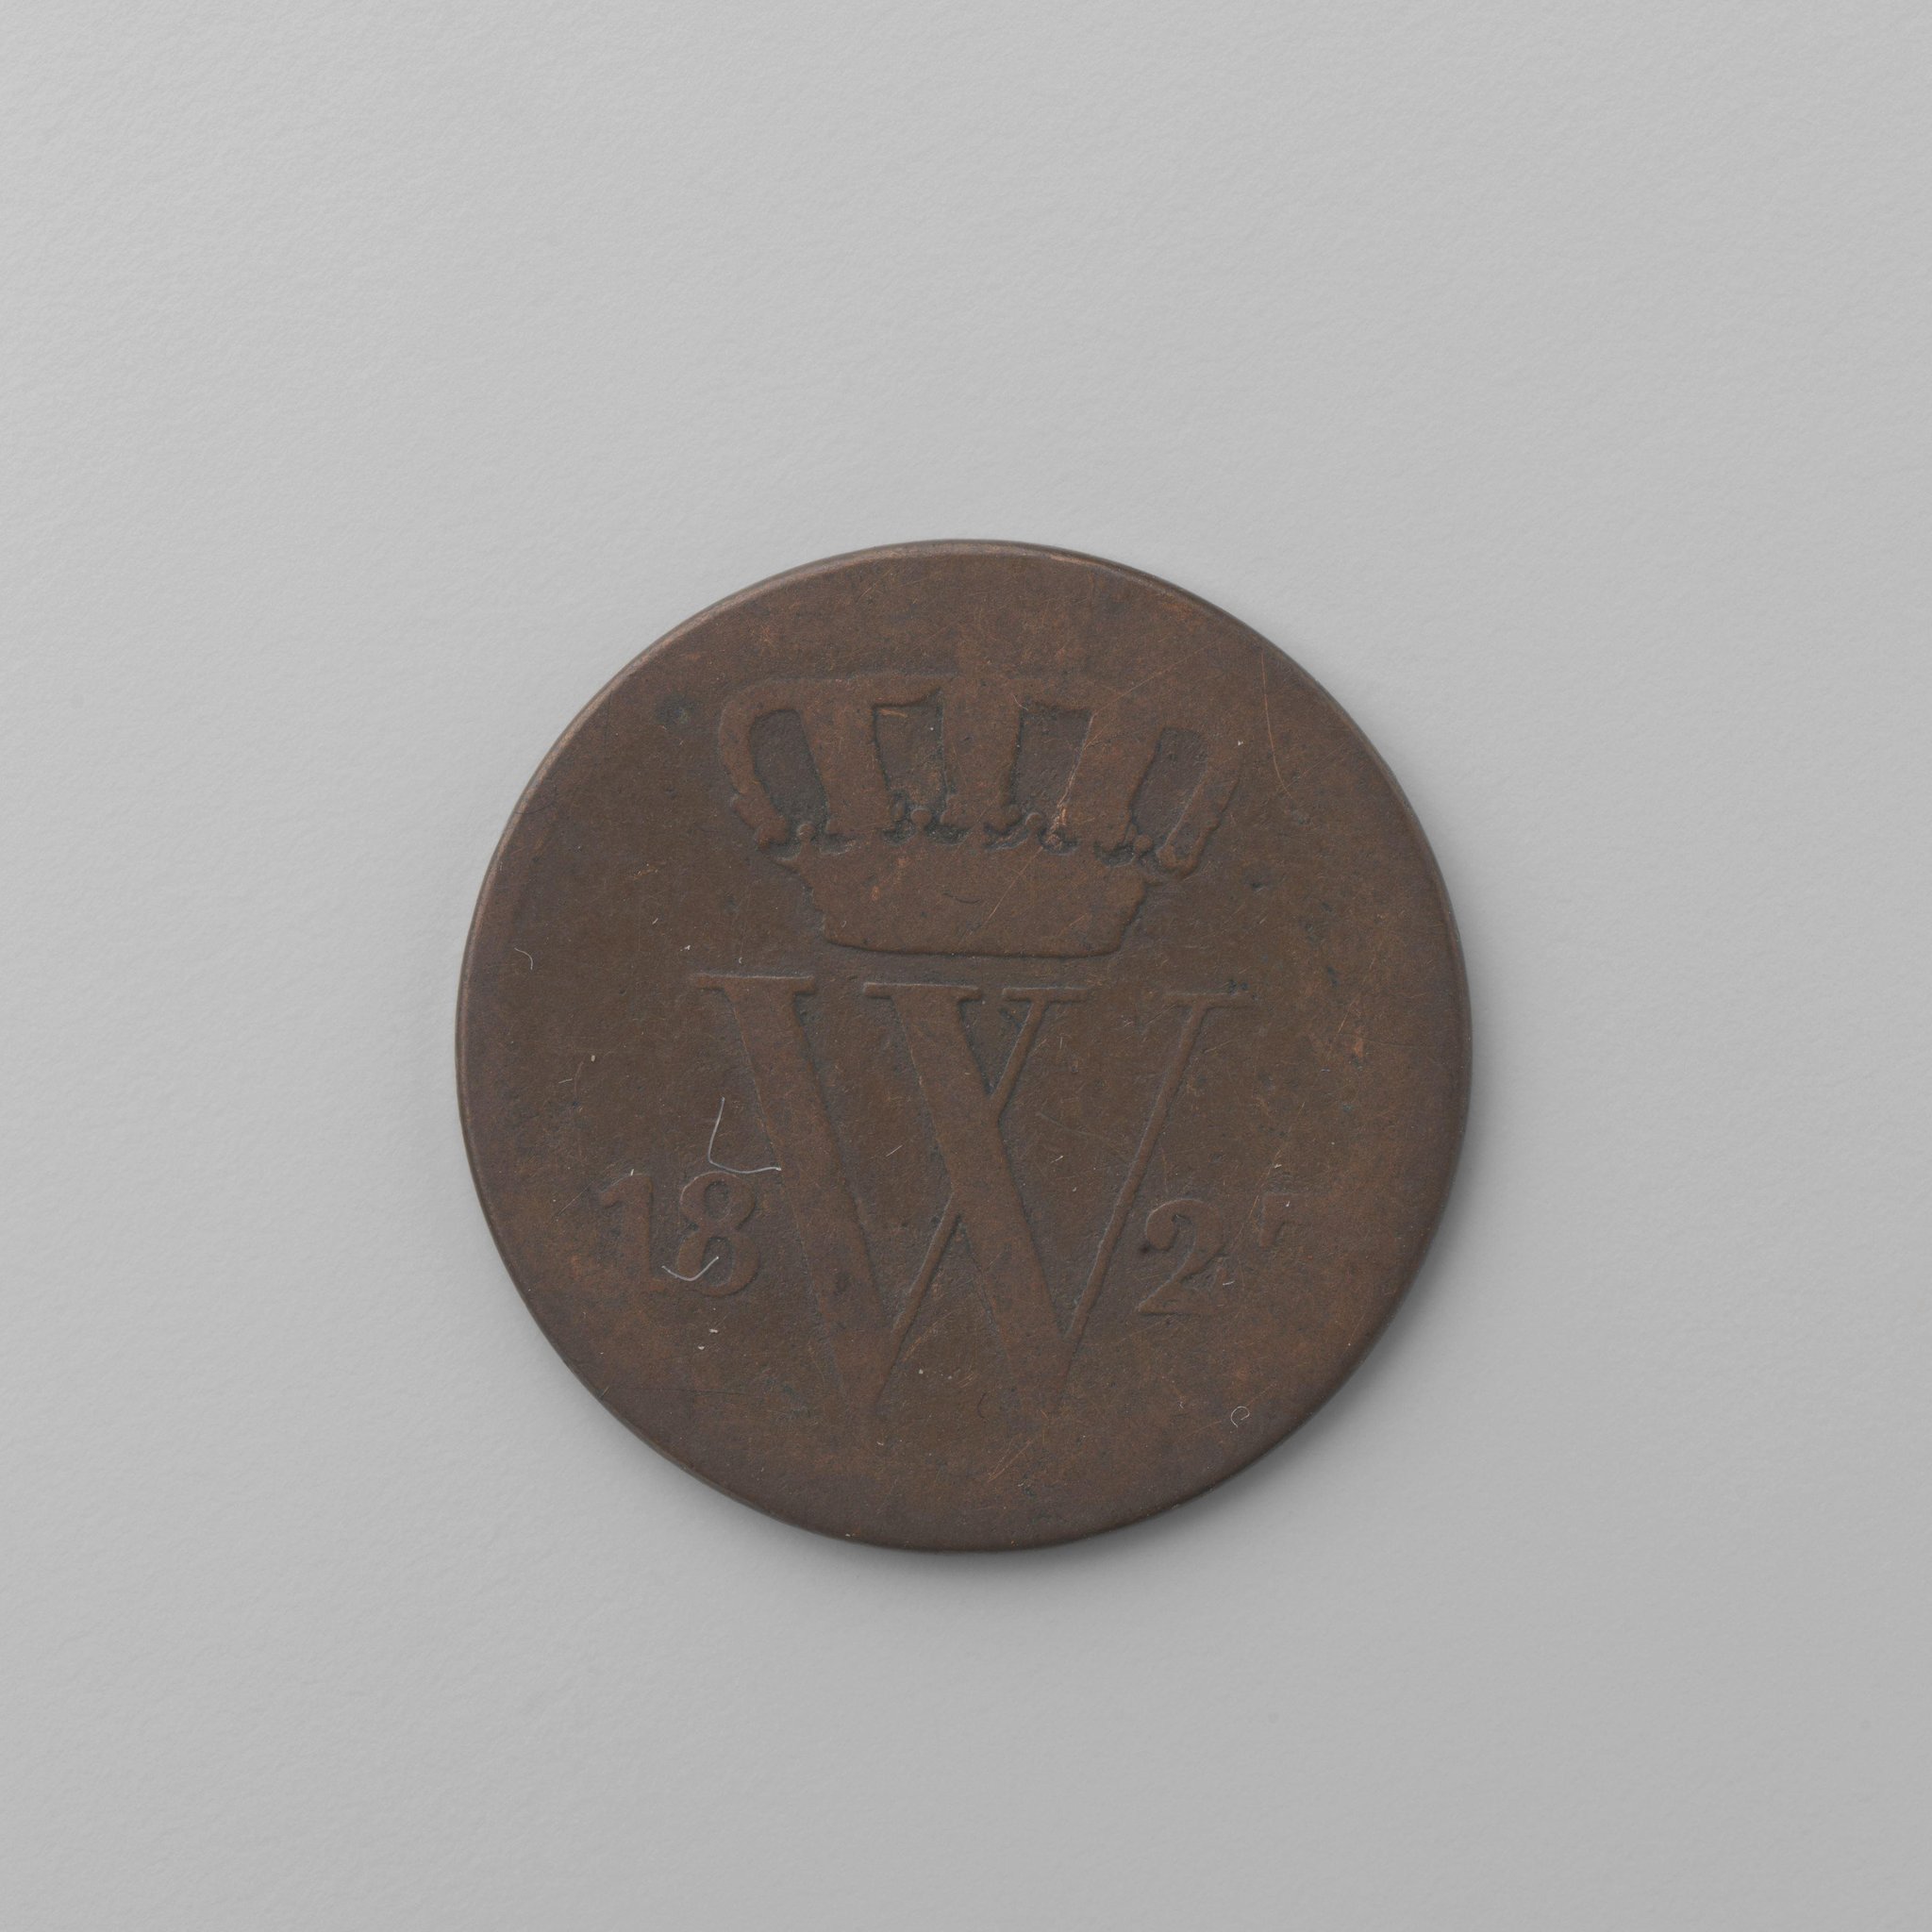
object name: coin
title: Nederland, cent, 1827 B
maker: william i of the netherlands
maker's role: koning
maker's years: 1772-1843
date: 1827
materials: copper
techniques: striking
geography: brussels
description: Koperen munt. Voorzijde: tussen jaartal gekroonde rechte letter W. Keerzijde: tussen waarde-aanduiding 1 C. gekroond rijkswapenschild. Gladde rand.